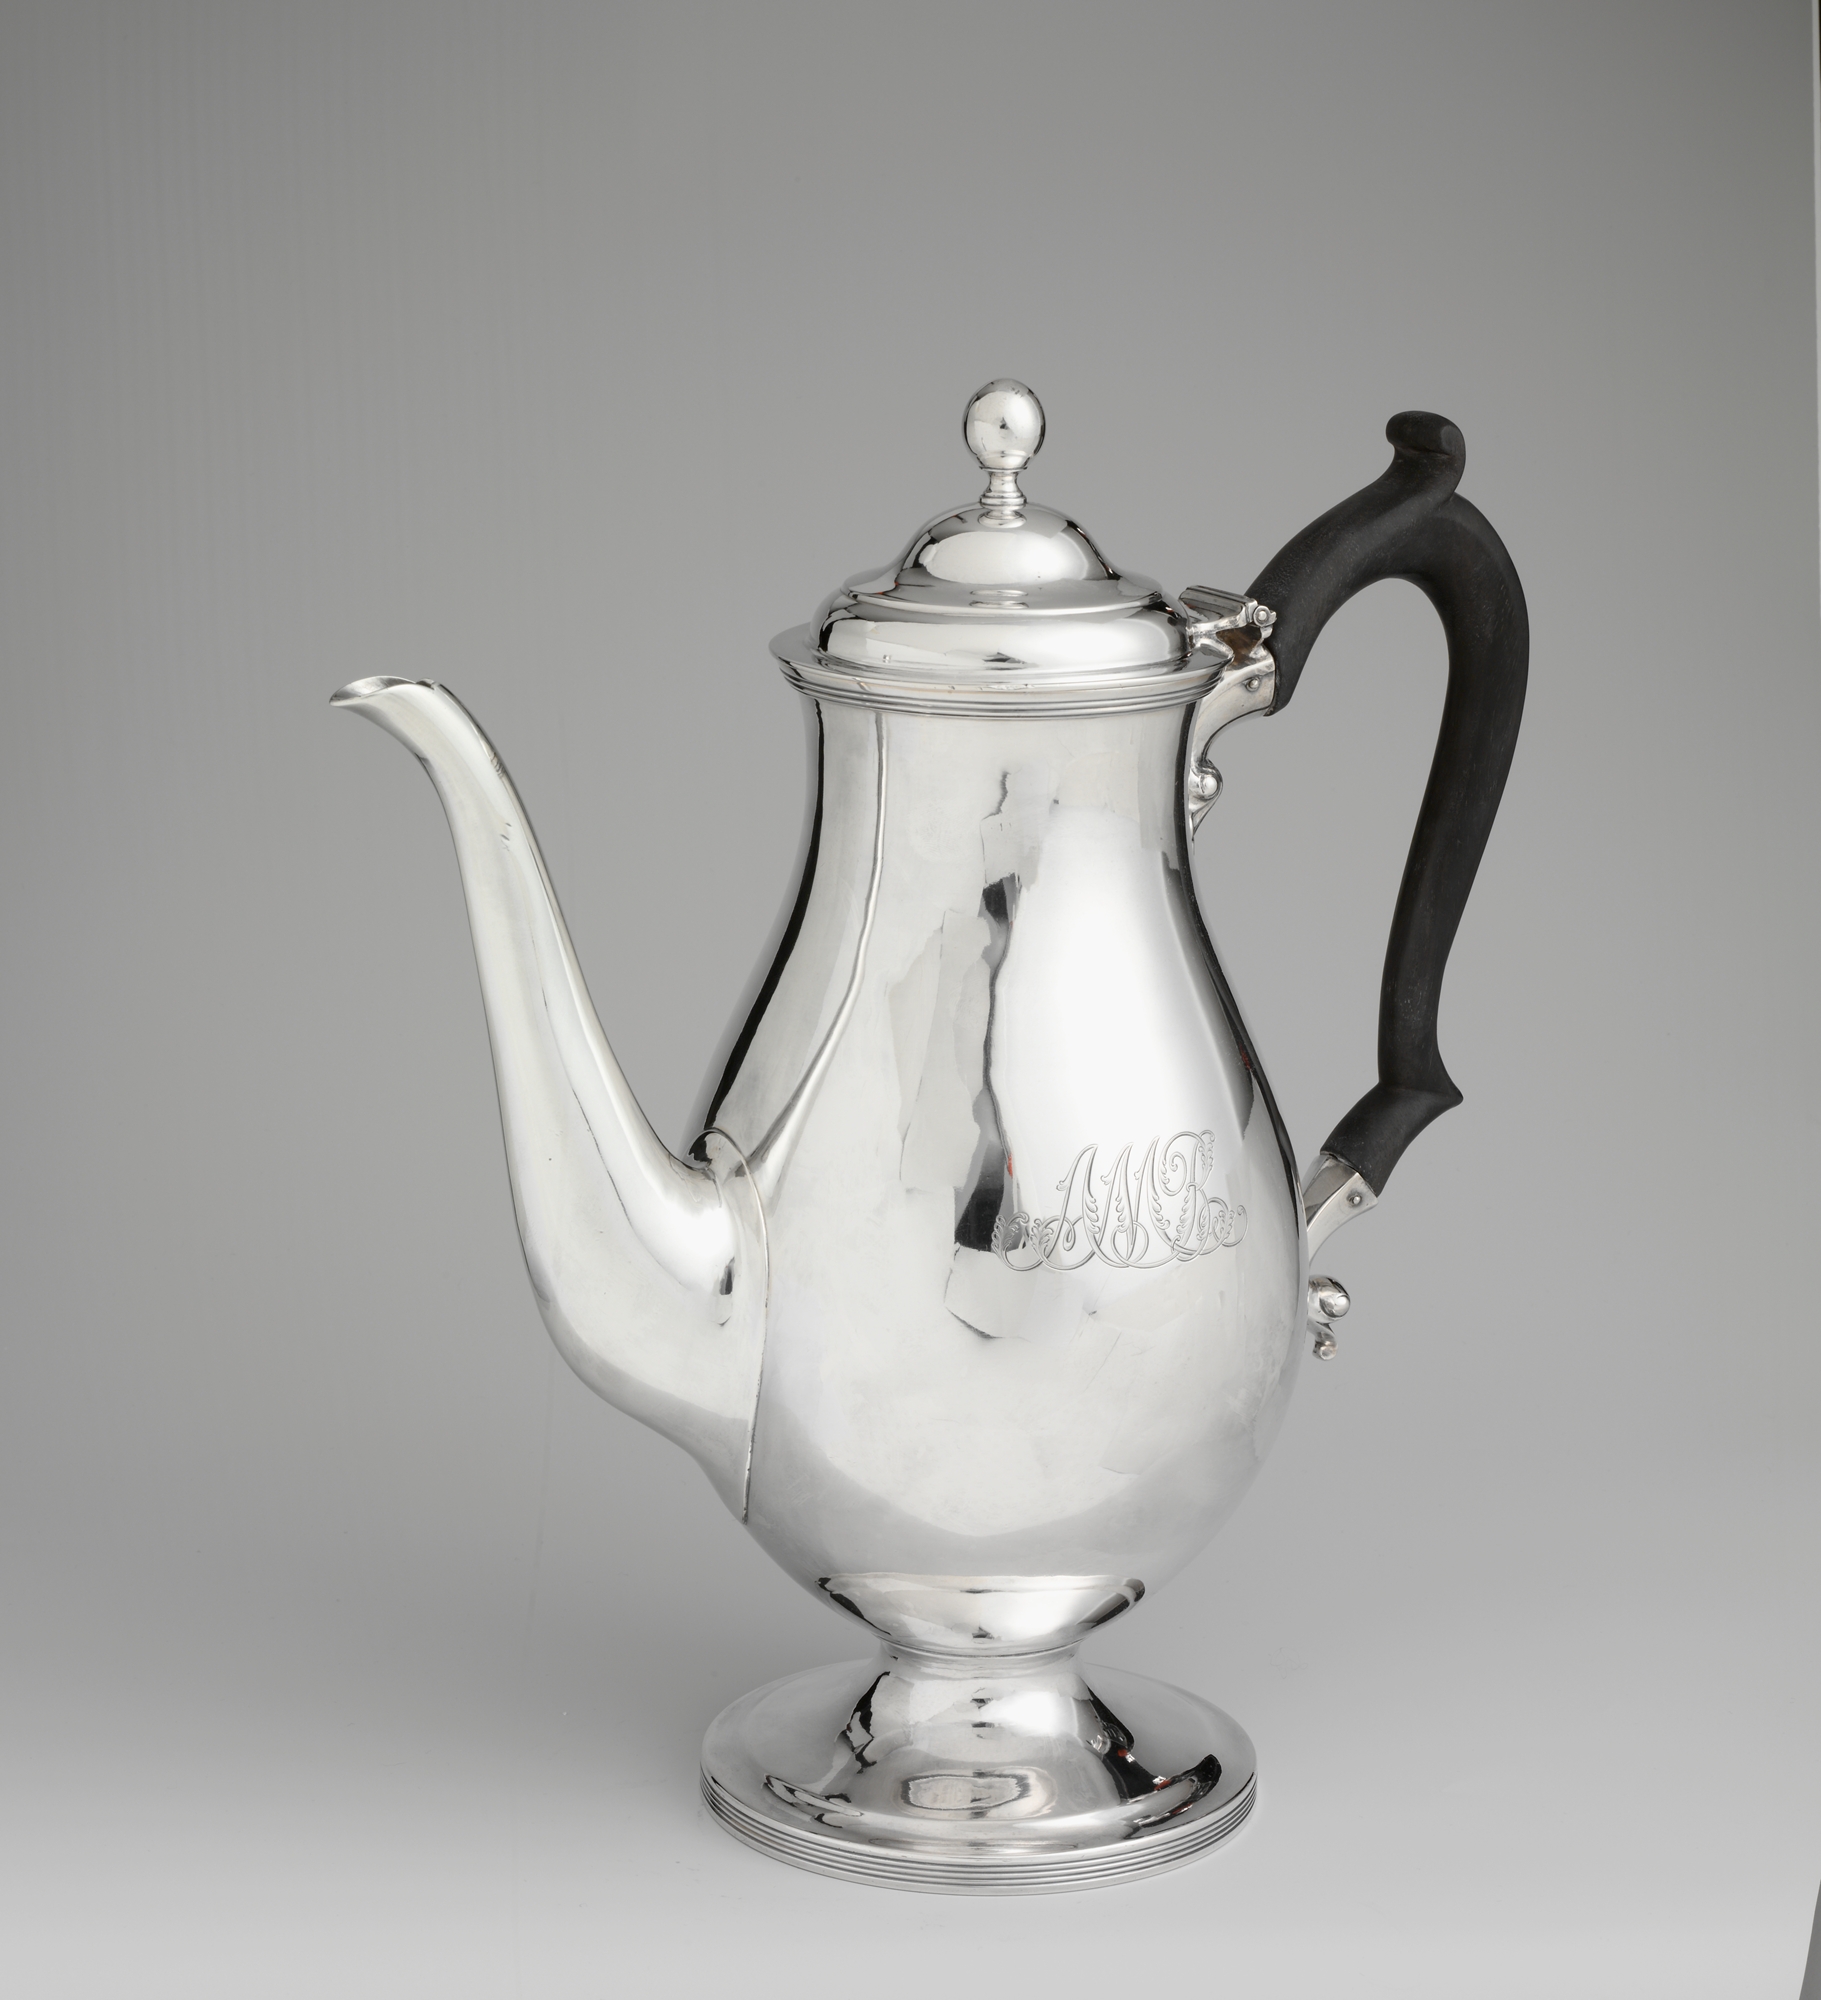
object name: coffeepot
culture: american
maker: john vernon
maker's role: maker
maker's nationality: american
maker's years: 1755-1845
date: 1790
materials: silver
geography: united states